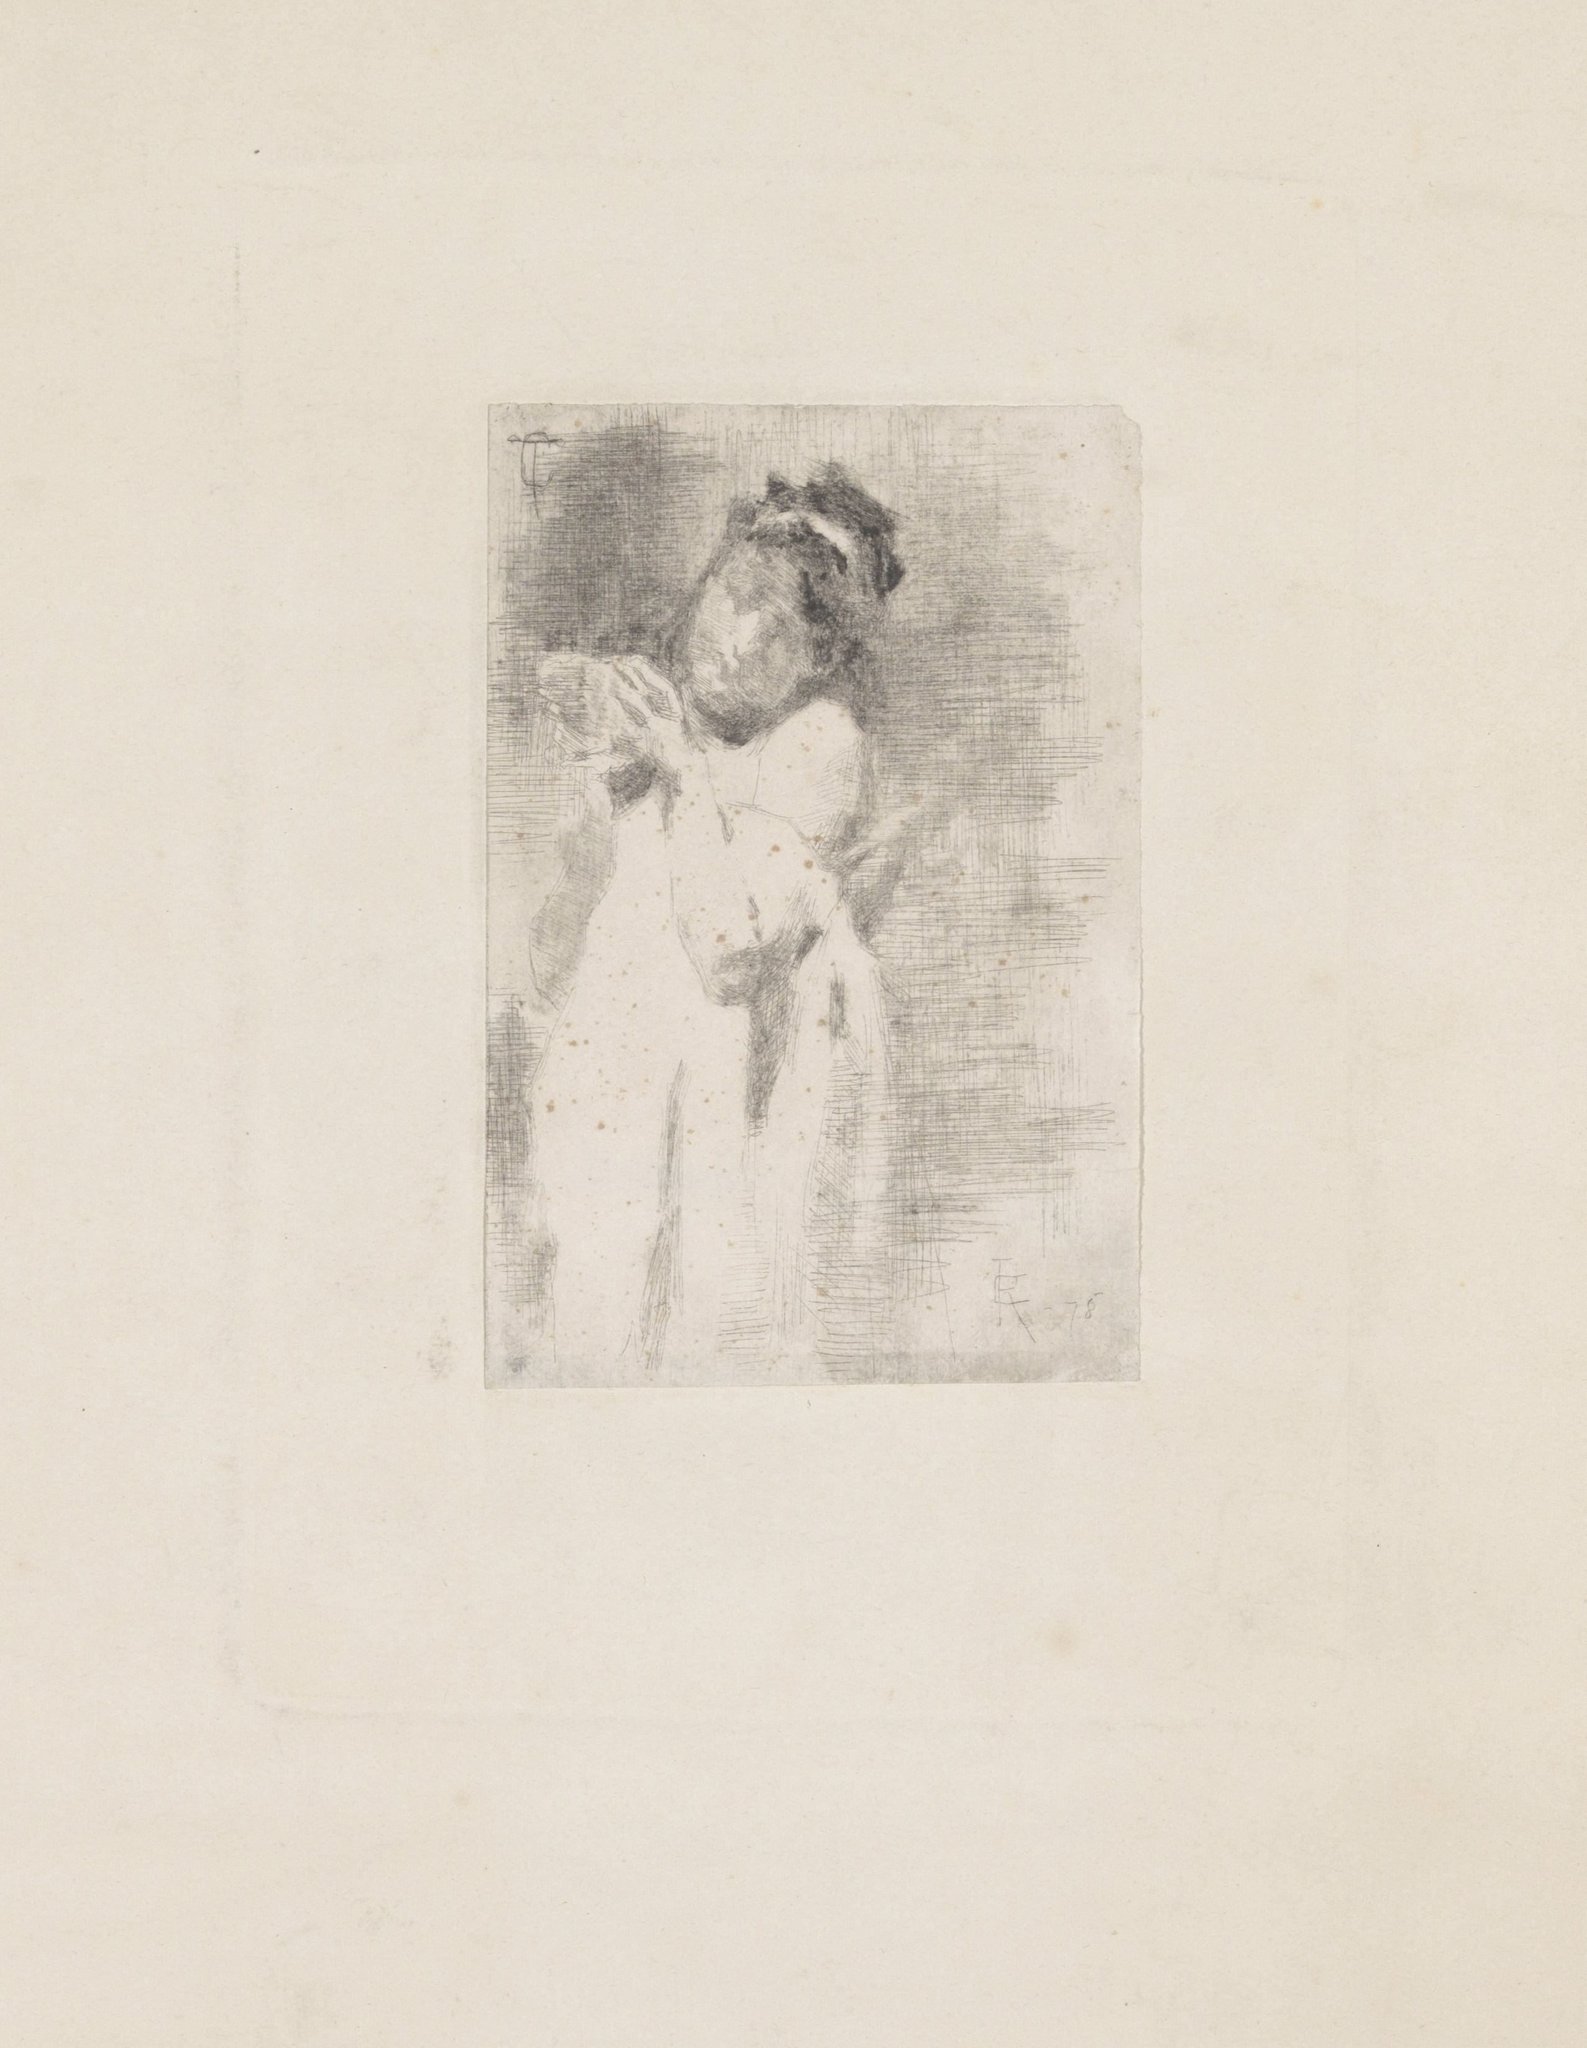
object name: print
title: Meisje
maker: roberto fontana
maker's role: draughtsman, print maker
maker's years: 1844-1907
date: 1878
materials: paper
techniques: etching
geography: milan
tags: girl (child between toddler and youth)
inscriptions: collector's mark: Lugt 2228